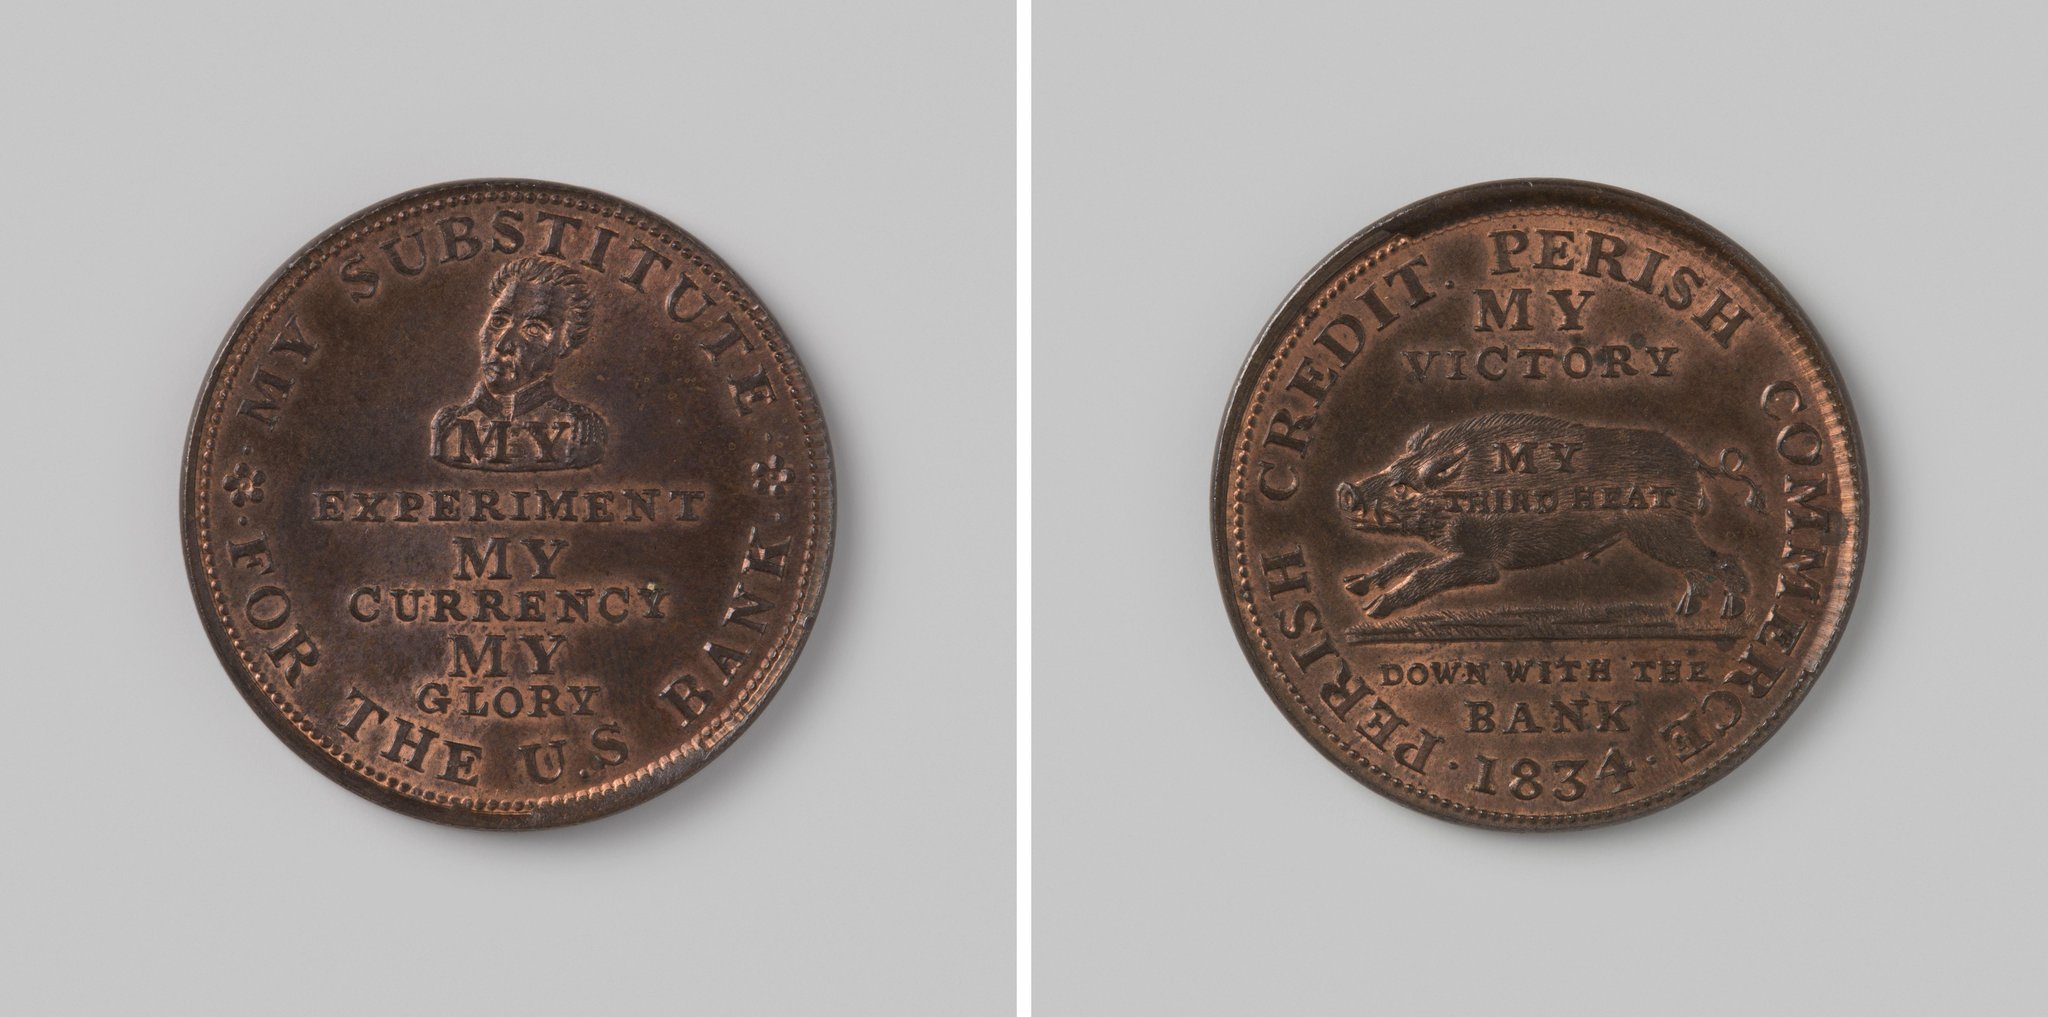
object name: history medal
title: Spotpenning op de Amerikaanse kredietcrisis van 1834 (hard times token)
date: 1834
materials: copper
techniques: striking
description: Koperen penning, op de voorzijde vijf regels tekst onder een klein borstbeeld van president Jackson naar links, met omschrift, op de keerzijde een rennend everzwijn naar links met vijf regels tekst en omschrift.